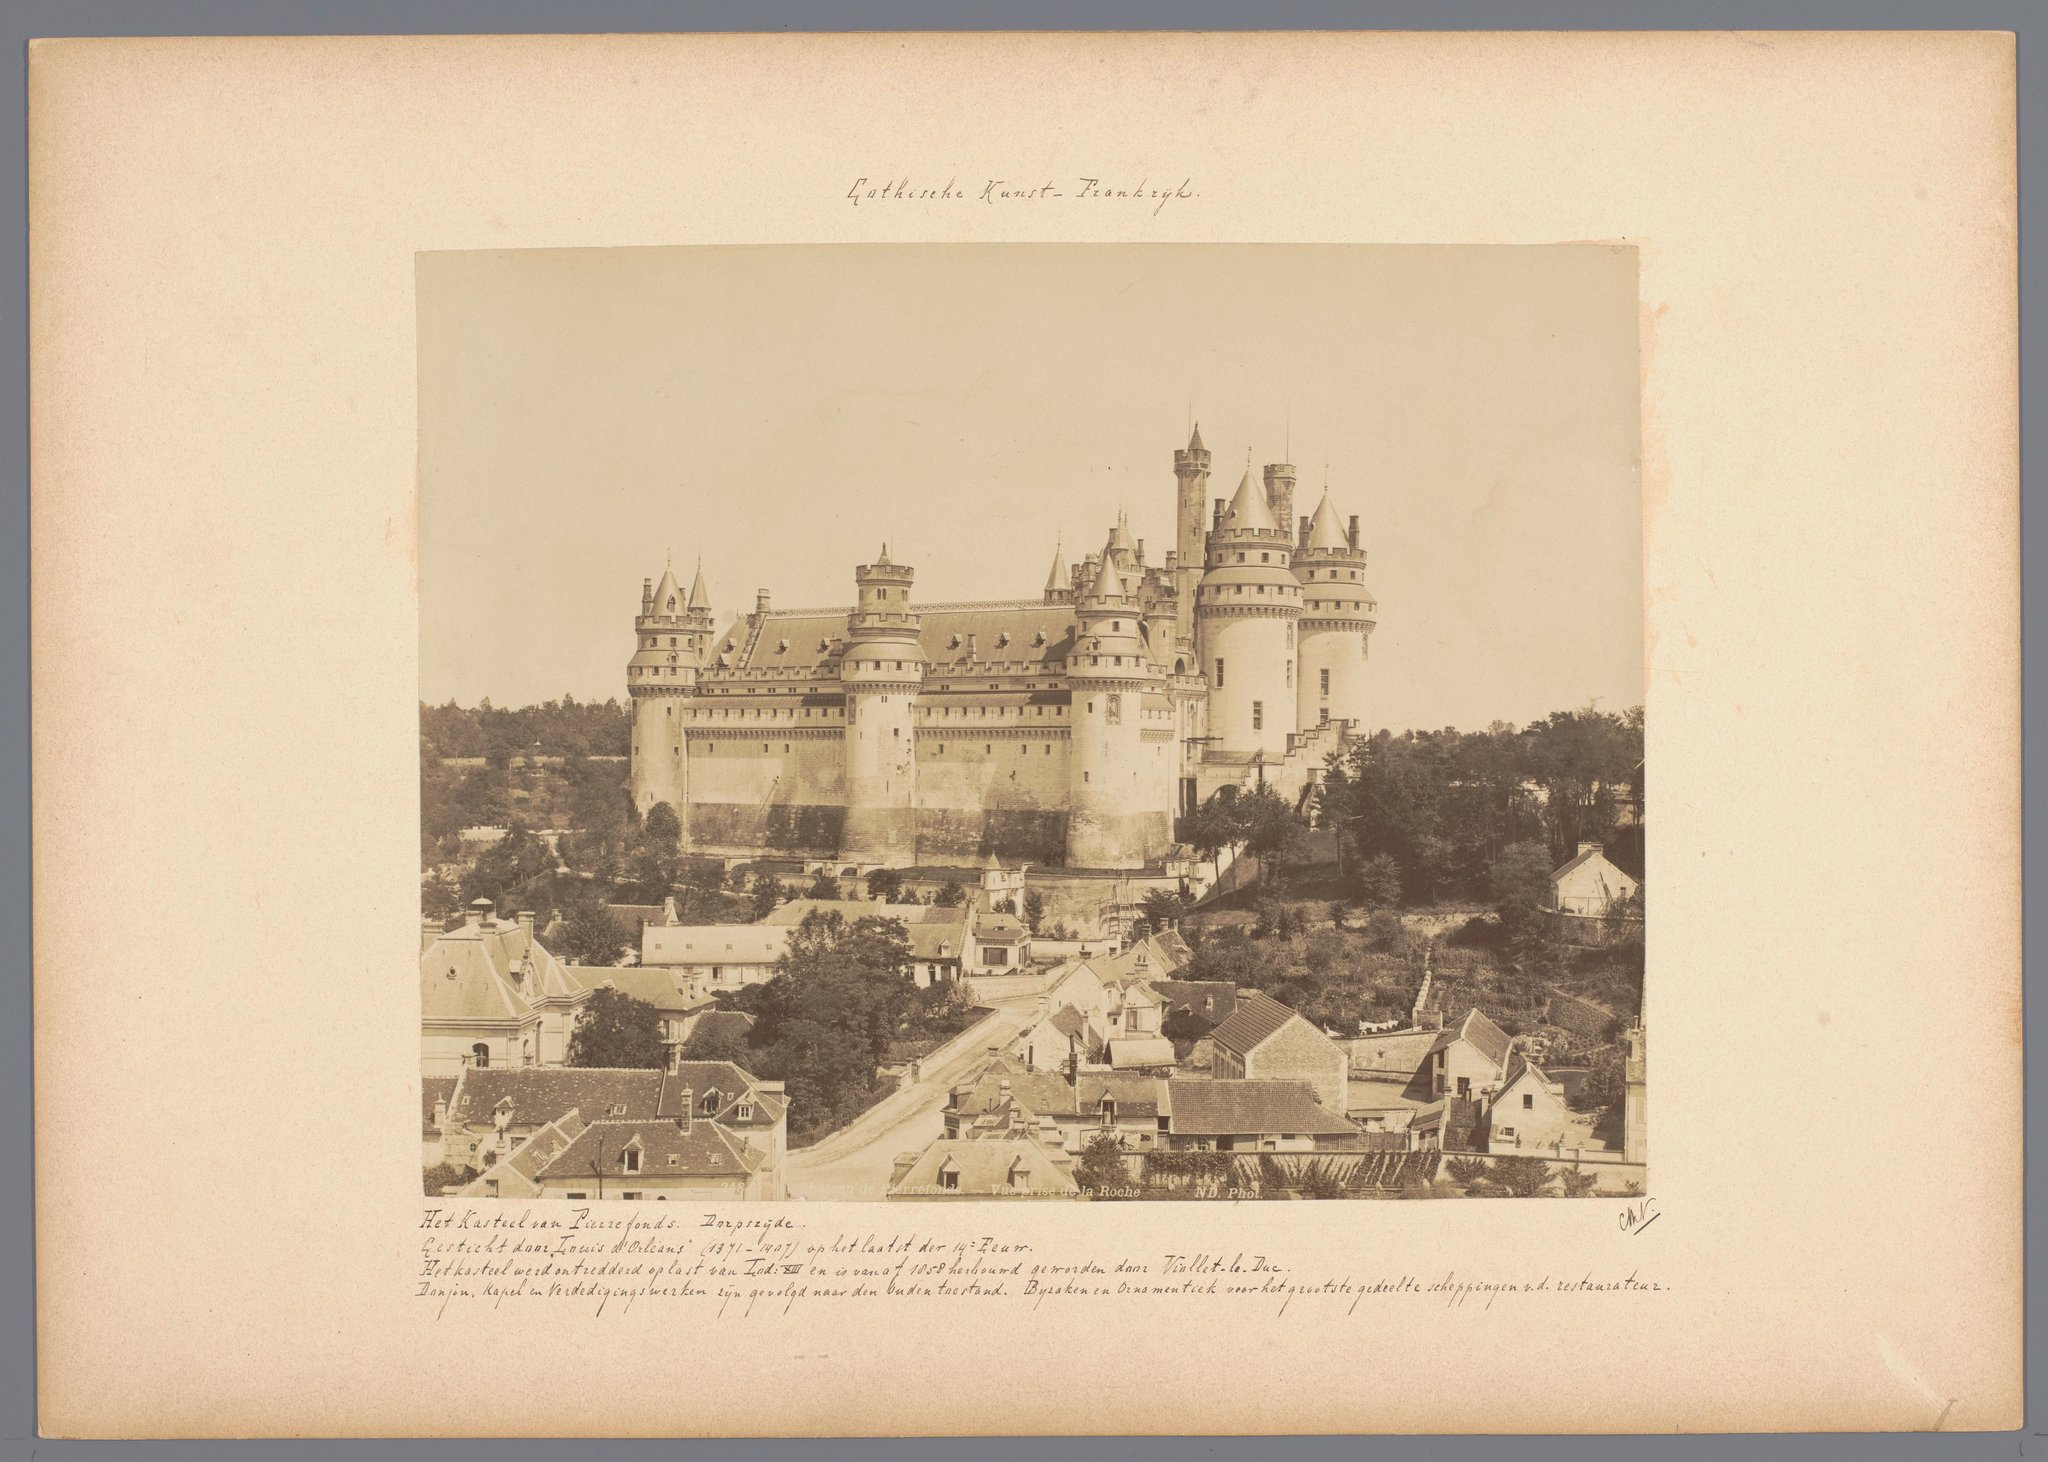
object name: photograph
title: Gezicht op het Kasteel van Pierrefonds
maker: étienne neurdein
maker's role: publisher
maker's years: 1832-1918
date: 1875-1900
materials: cardboard, photographic support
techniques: albumen print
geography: pierrefonds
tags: city-view, and landscape with man-made constructions, landscape with tower or castle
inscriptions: collector's mark: ‘INSTITUUT VOOR KUNST-NIJVERHEIDSONDERWIJS GABRIËL METSUSTRAAT No. 16 AMSTERDAM’, number: ‘248’, inscription: ‘CWN.’, collector's mark: ‘KUNSTNIJVERHEIDSCHOOL QUELLINUS AMSTERDAM FRANS HALSSTRAAT 14.’, inscription: ‘Gothische Kunst - Frankrijk.’